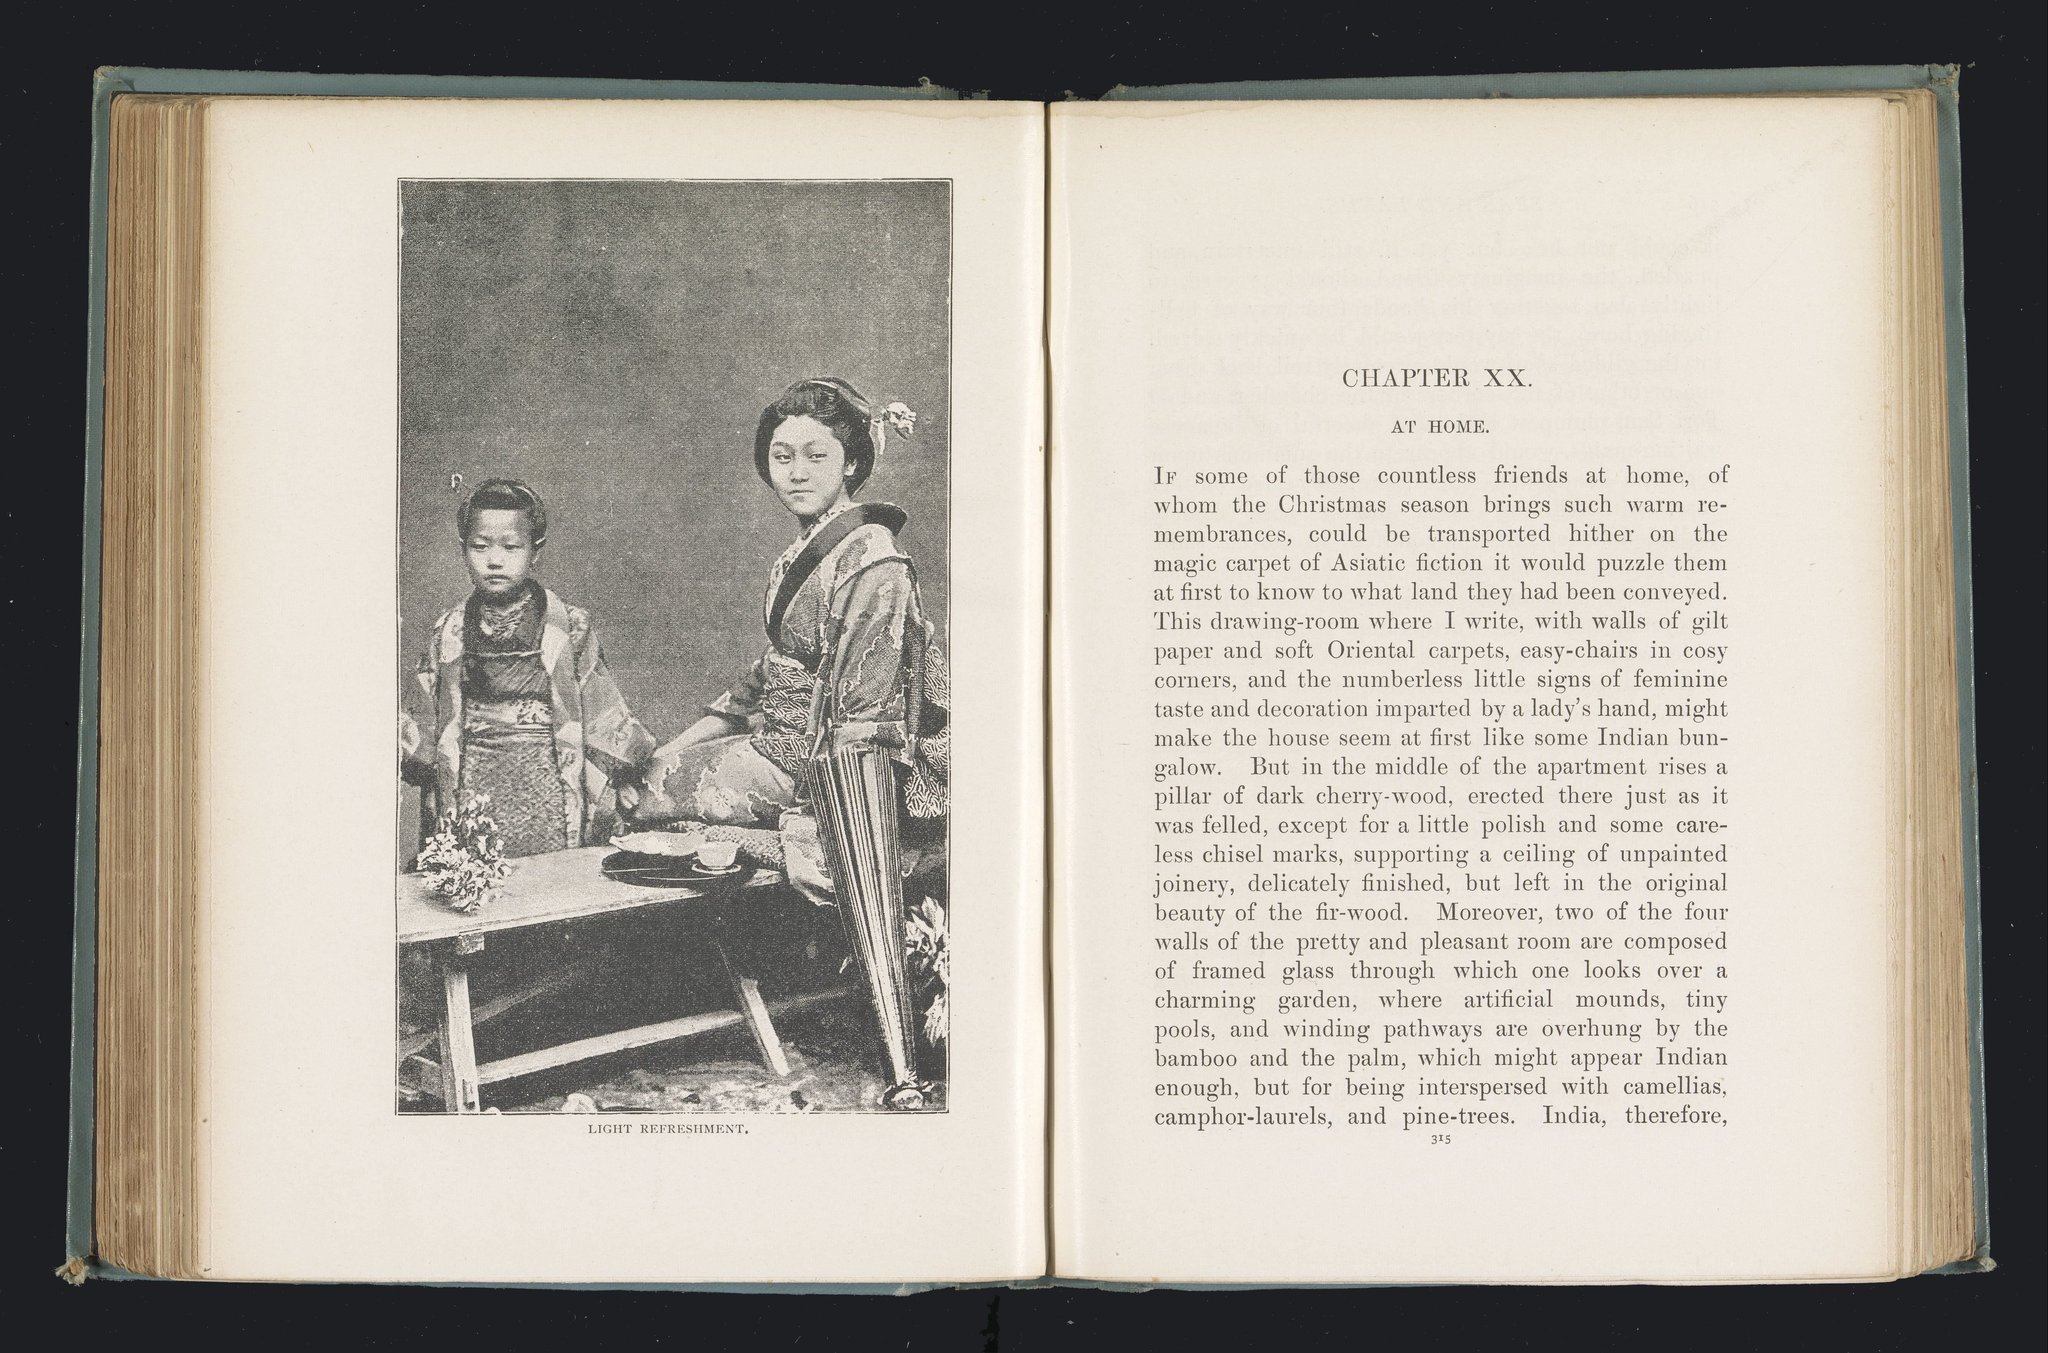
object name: page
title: Light refreshment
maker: Anonymous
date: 1882-1892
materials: paper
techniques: autotype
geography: japan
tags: folk costume, regional costume